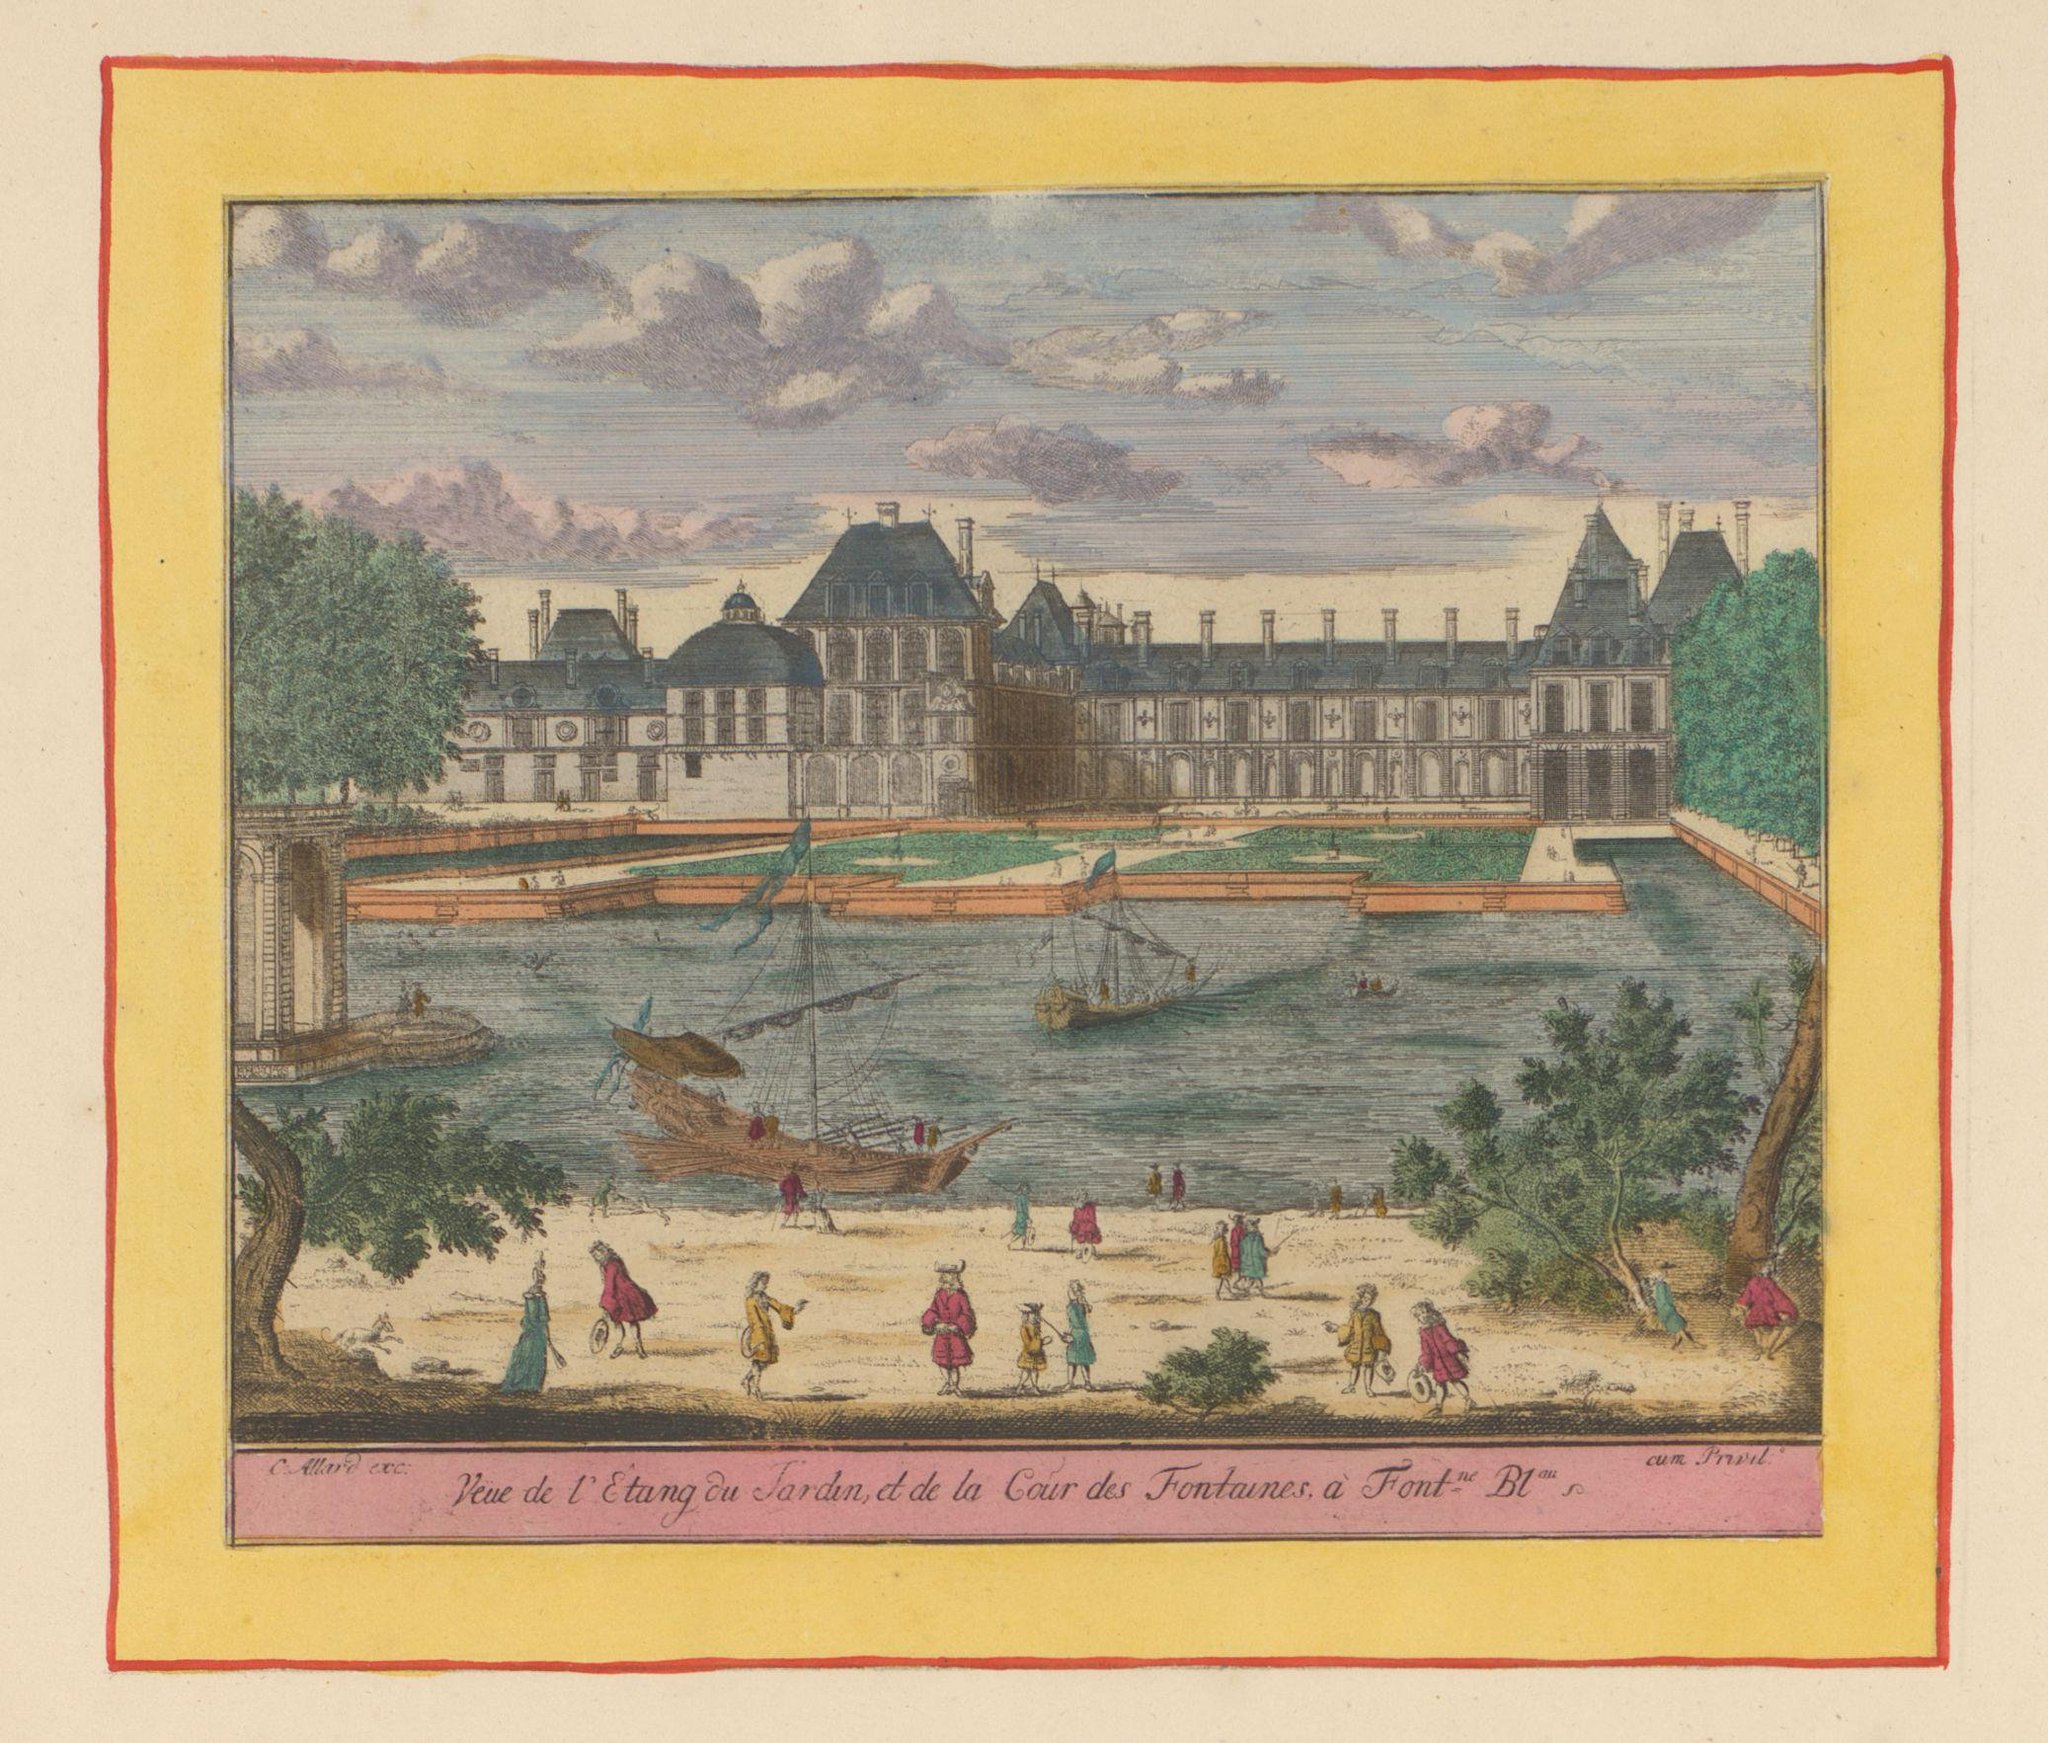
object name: album leaf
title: Veue de l'Etang de Jardin, et de la Cour des Fontaines, à Fontne. Blau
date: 1684-1709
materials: paper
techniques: etching, hand coloring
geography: amsterdam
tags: palace, french or architectonic garden; formal garden, garden pond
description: De Cour de la Fontaine in de tuin van het paleis van Fontainebleau. Op het water van de vijver varen twee boten, op de voorgrond staan figuren bij de waterkant. Prent maakt deel uit van een album.